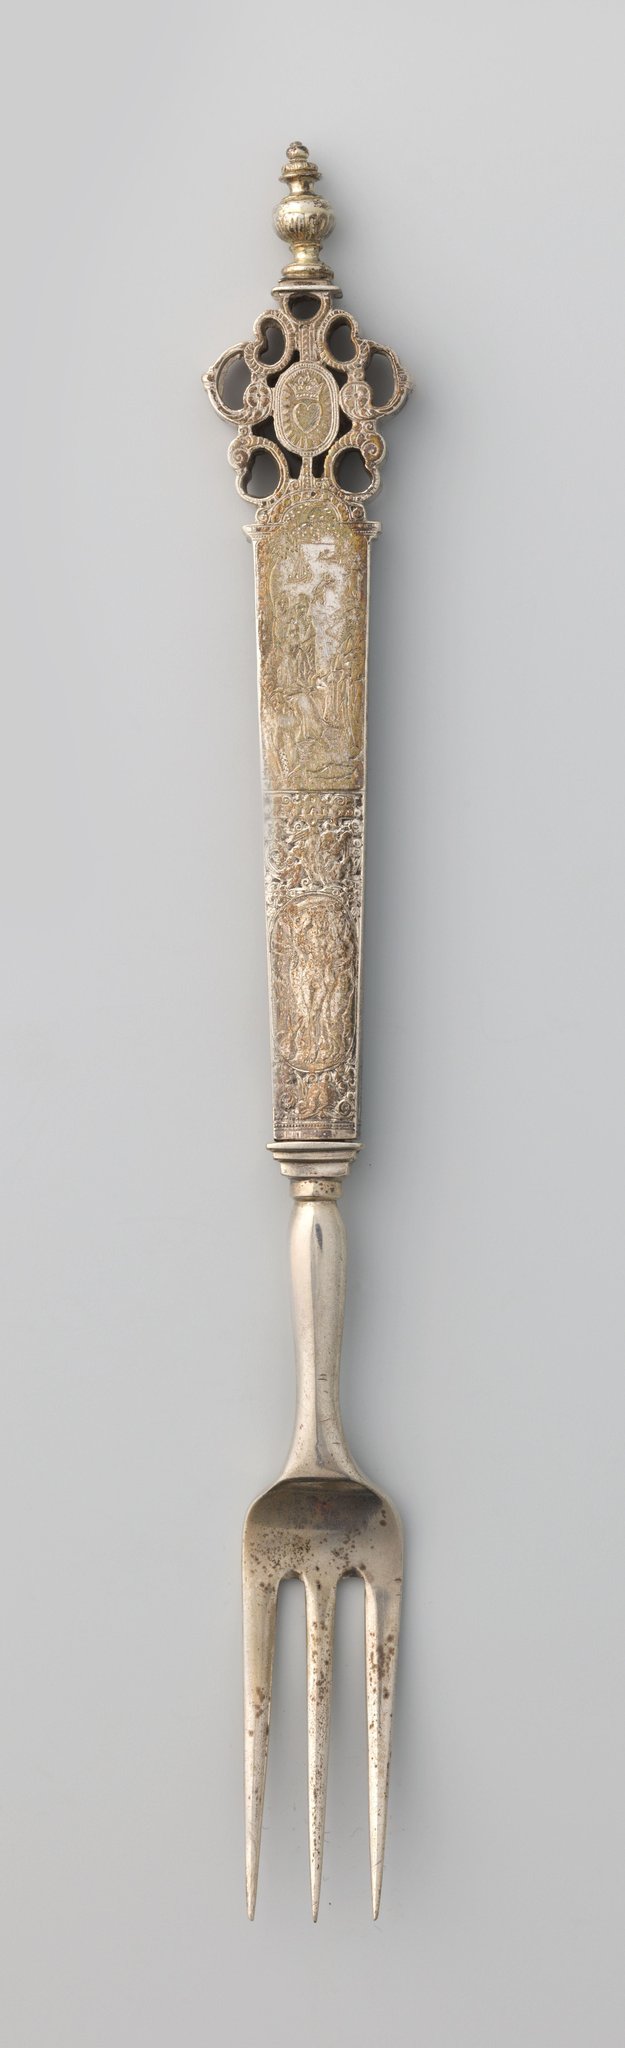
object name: fork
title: Vork van zilver met geheel gegraveerde steel. Top met uitgesneden ornament. Geheel eindigt in vorm van een vaas.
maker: johann theodor de bry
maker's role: print maker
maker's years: 1561-1623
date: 1575-1600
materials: silver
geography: southern netherlands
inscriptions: mark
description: Two forks. Silver. Netherlands, c. 1575-1600.